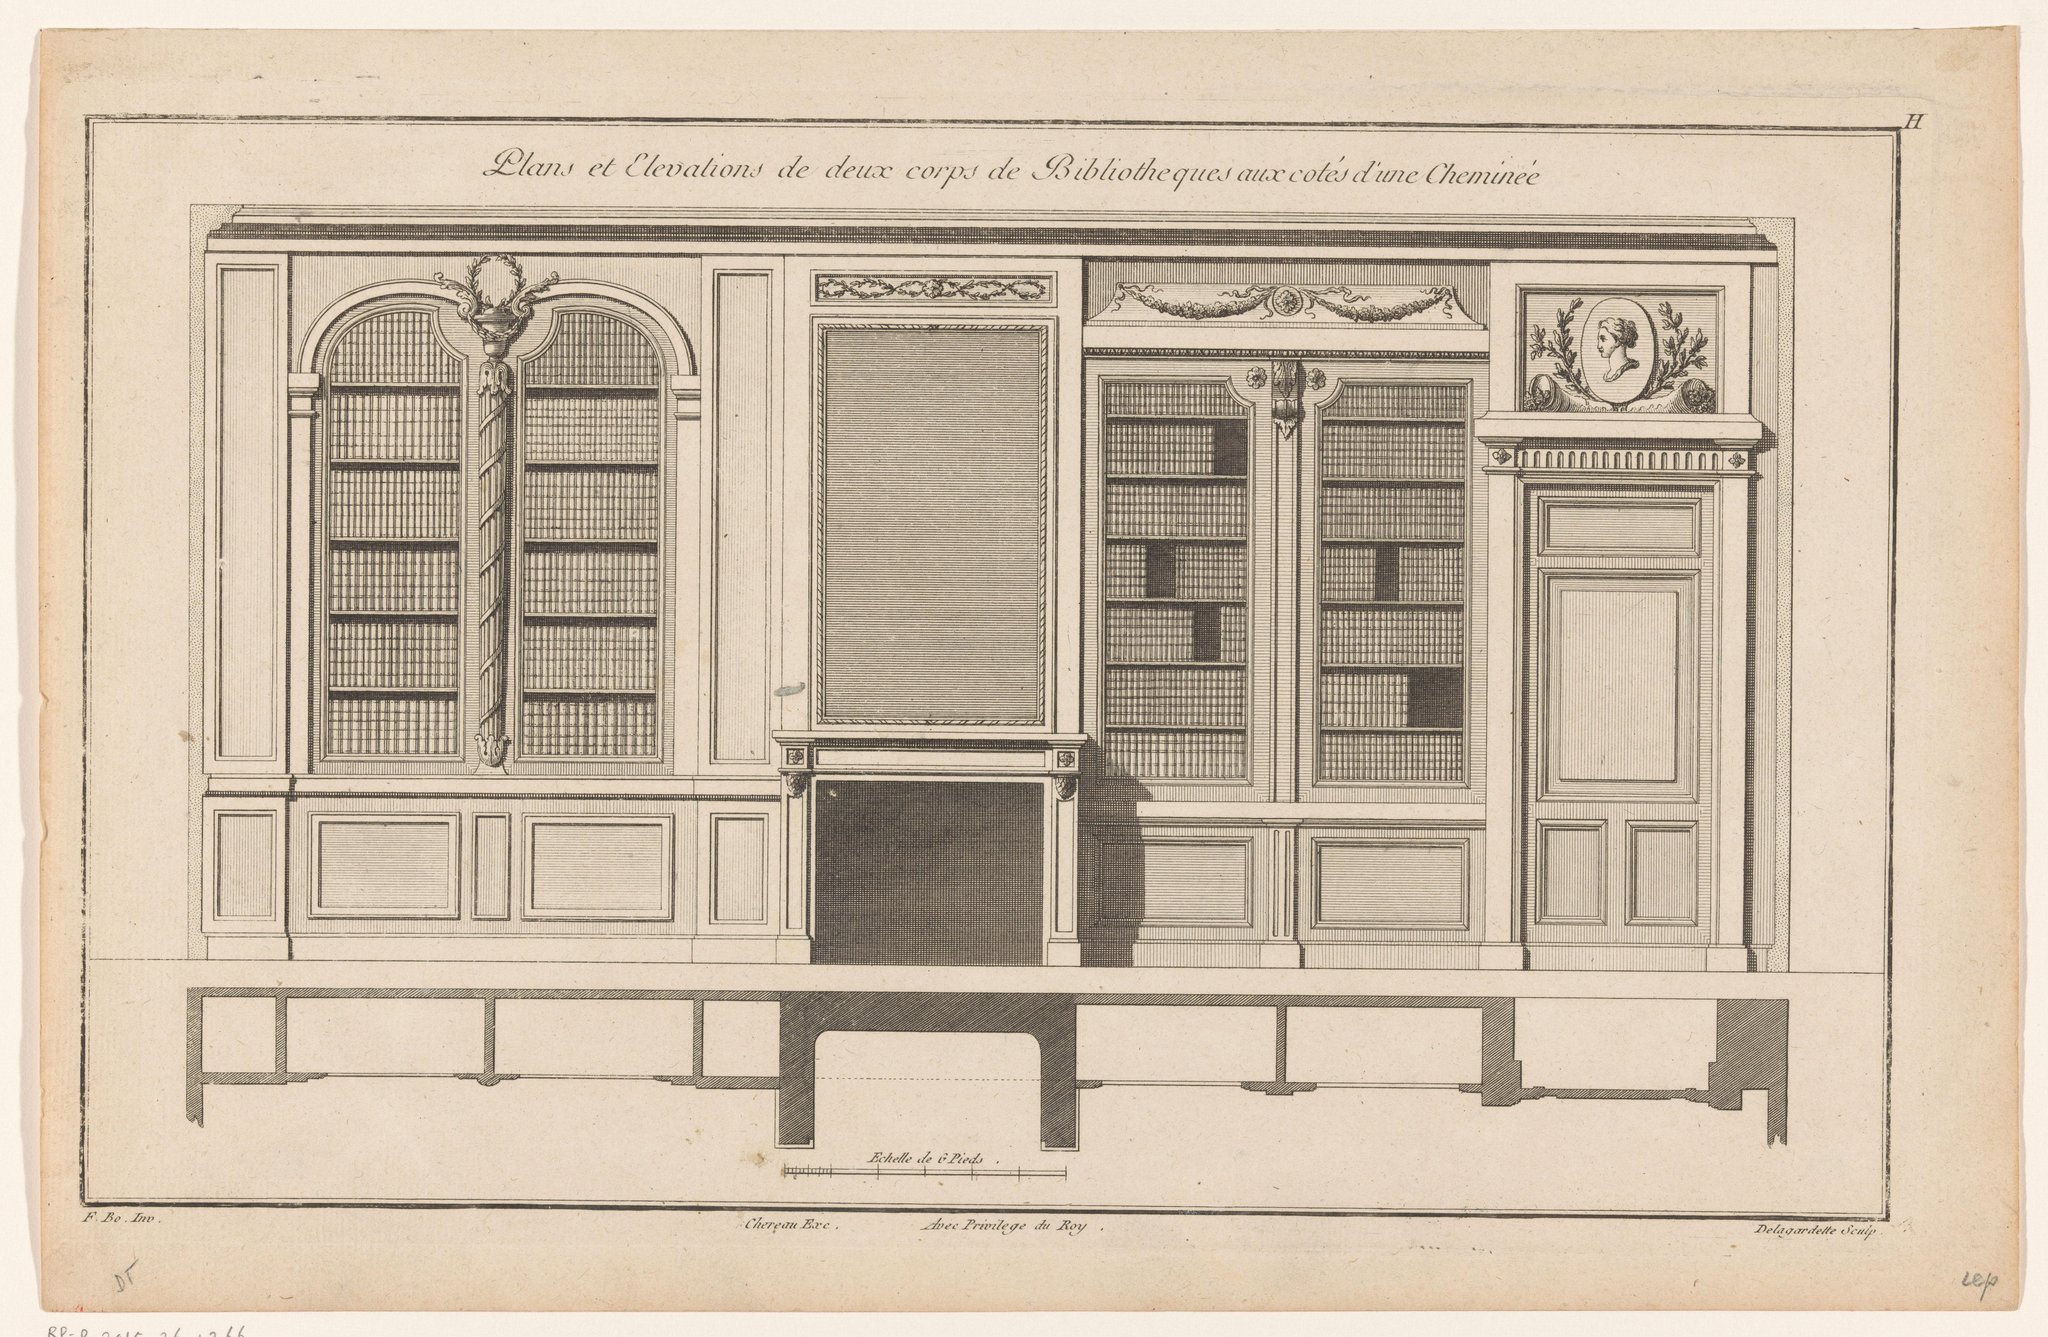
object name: print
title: Plans et Elevations de deux corps de Bibliotheques aux cotés d'une Cheminée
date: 1753-1782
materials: paper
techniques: engraving, etching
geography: paris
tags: bookshelves, ornament ~ medallion, open hearth, fire-place, door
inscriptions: collector's mark: Lugt 4780, collector's mark: Lugt 2228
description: Ontwerp en plattegrond van twee boekenkasten aan weerszijden van een schouw. Rechts een deur met dessus-de-porte met een vrouwenportret en profil in een ovaal medaillon.